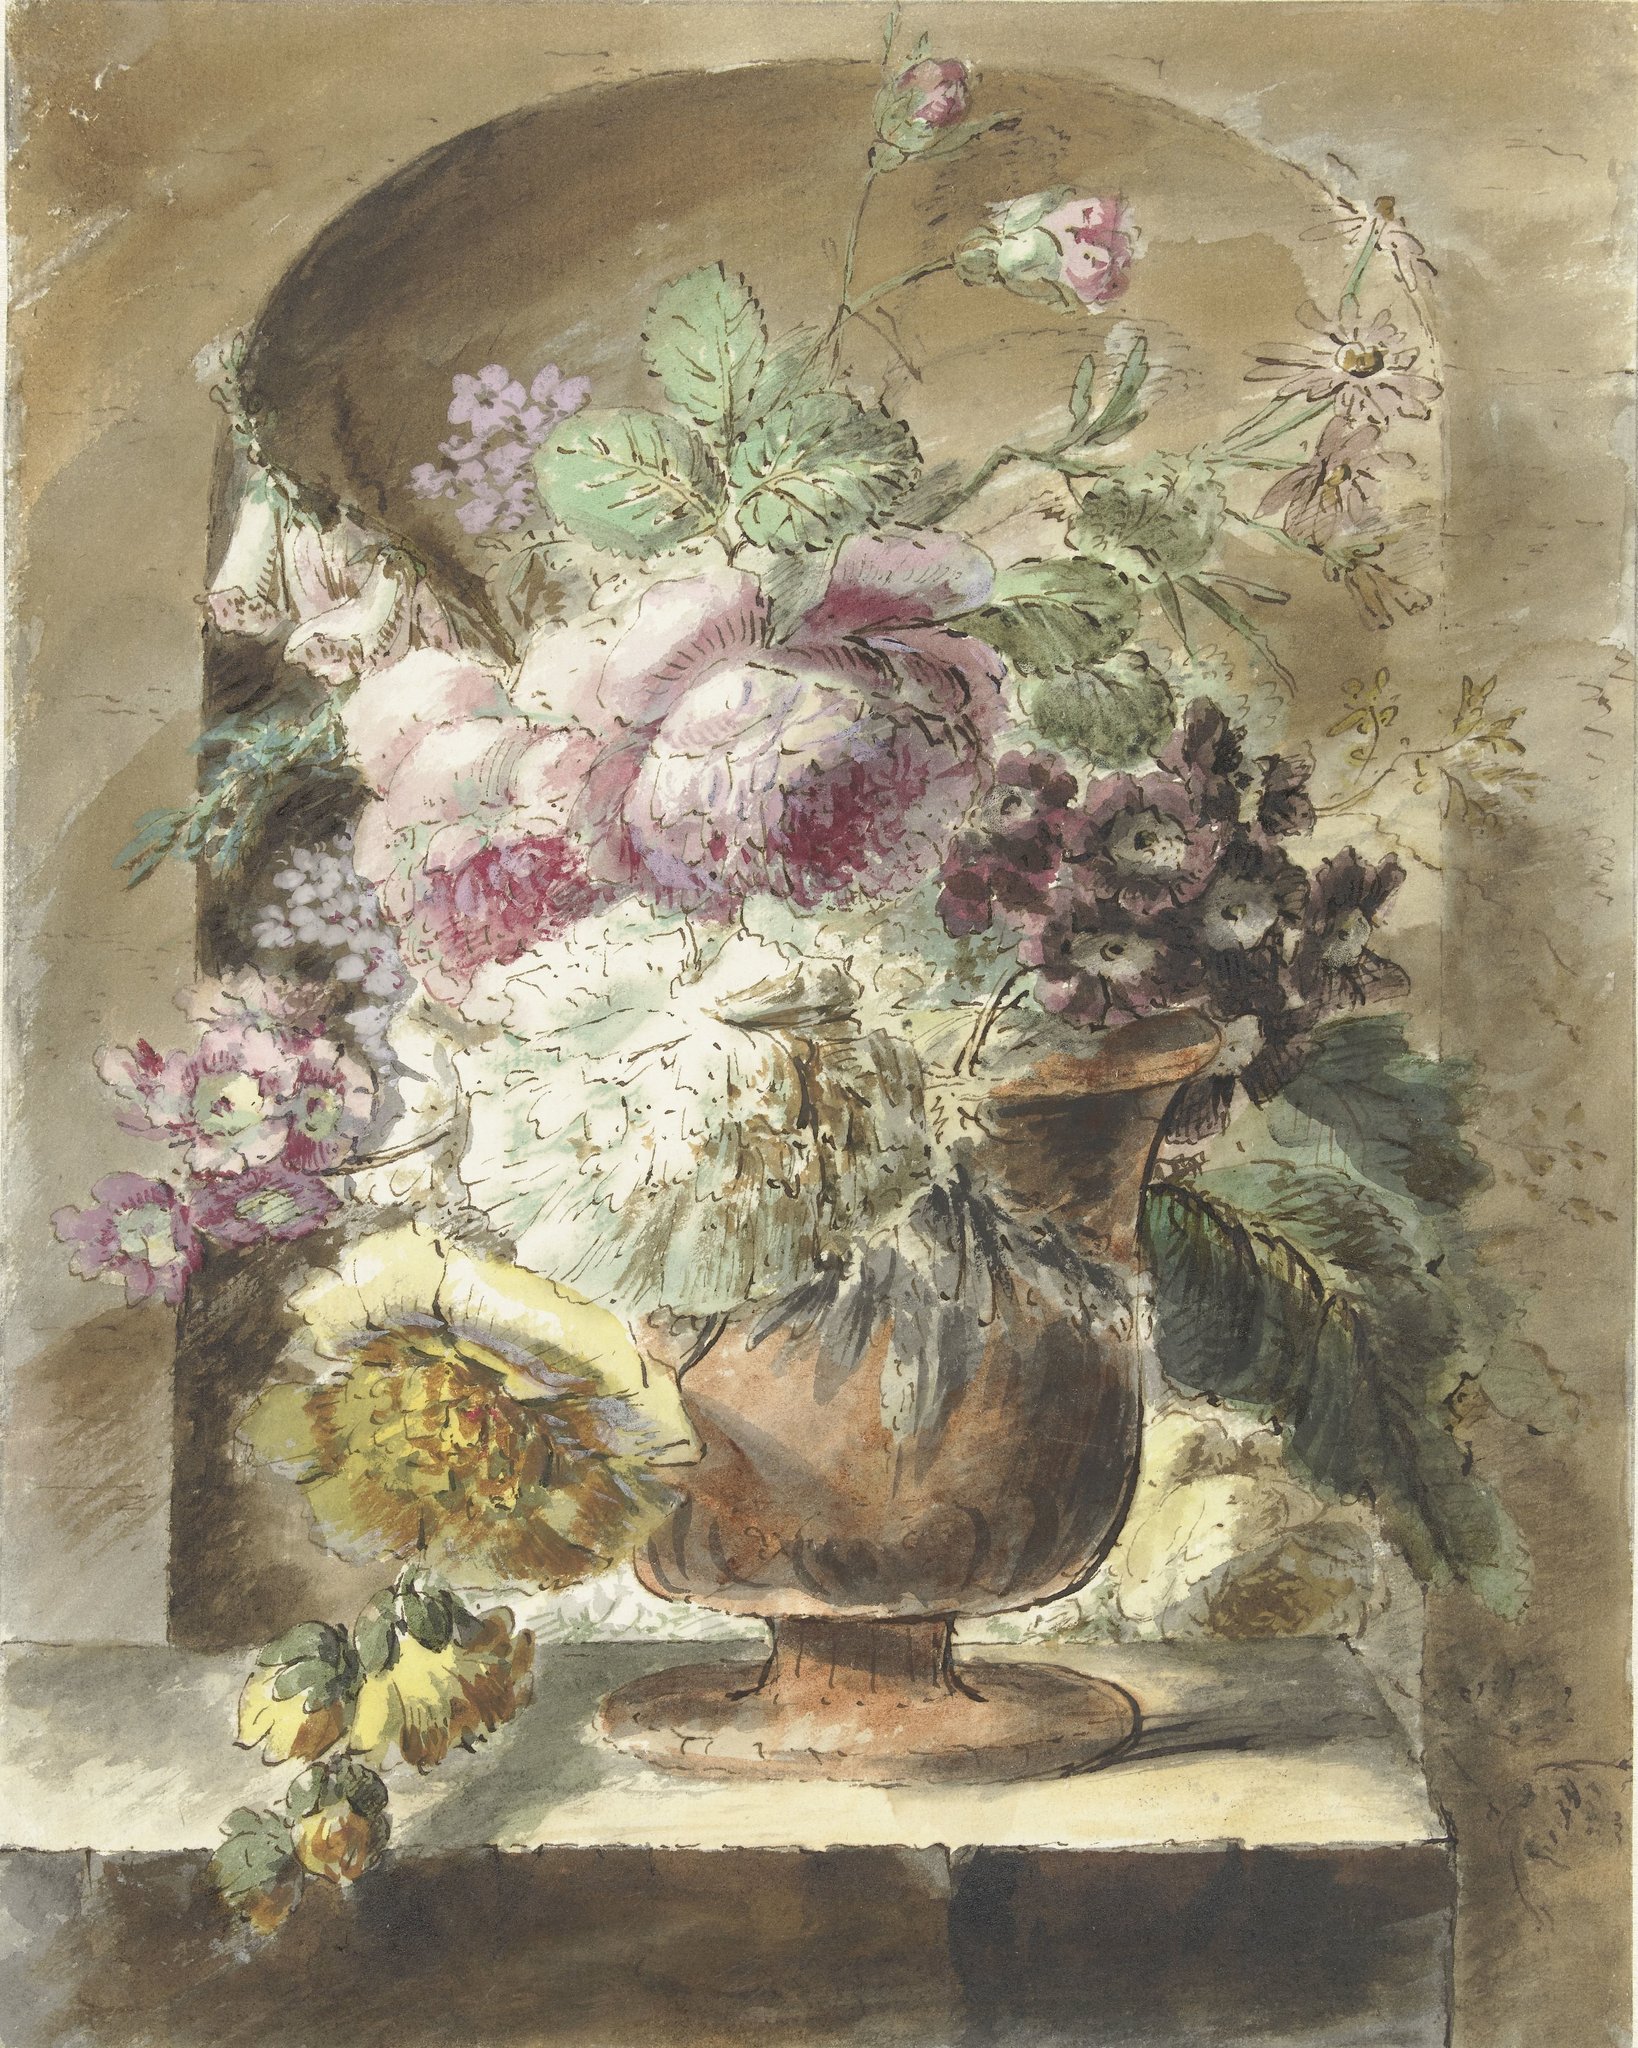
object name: drawing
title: Bloemen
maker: pieter van loo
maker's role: draughtsman, painter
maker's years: 1735-1784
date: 1745-1784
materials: paint, ink, paper, watercolor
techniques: brush, pen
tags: cut flowers; nosegay, bunch of flowers, flowers in a vase